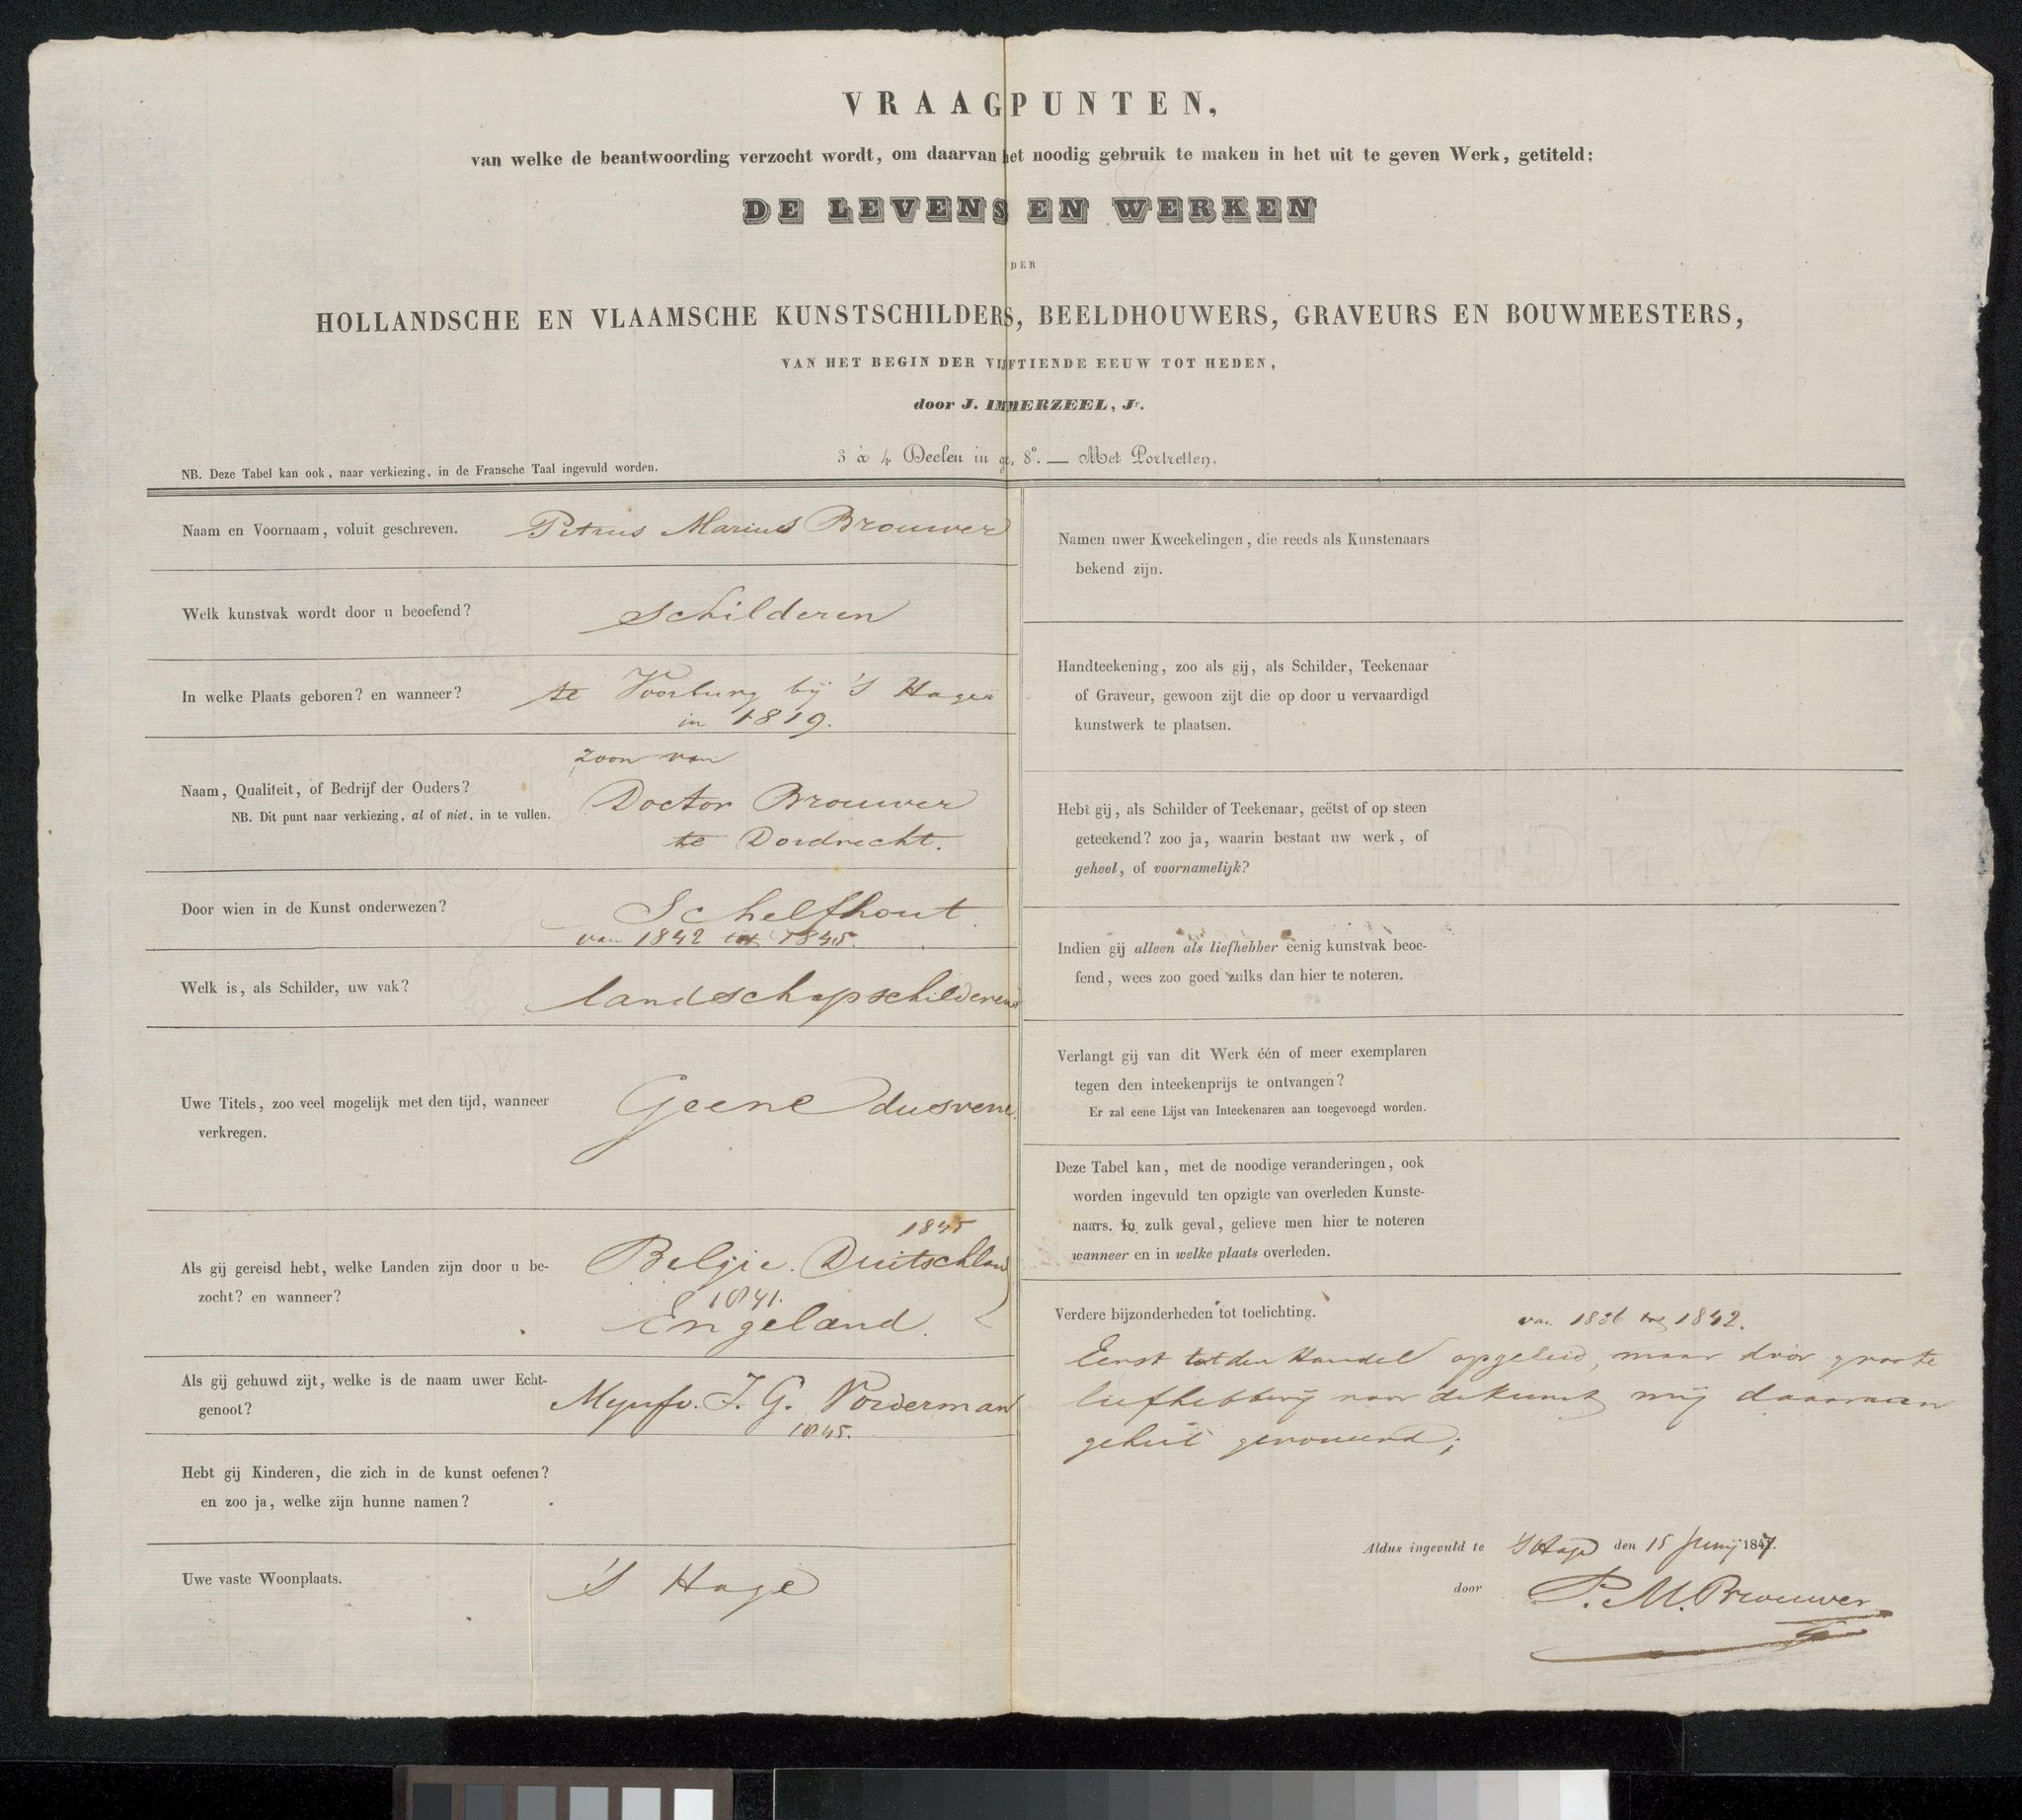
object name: questionnaire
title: Enquêteformulier ingevuld door Petrus Marius Brouwer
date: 1847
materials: ink, paper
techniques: pen, printing, writing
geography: the hague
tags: voorburg, deventer, draughtsman, petrus marius brouwer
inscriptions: inscription: ‘Vraagpunten,/ van welke de beantwoording verzocht wordt, om daarvan het noodig gebruik te maken in het uit te geven Werk, getiteld: De levens en werken/ der Hollandsche en Vlaamsche kunstschilders, beeldhouwers,/ graveurs en bouwmeesters, van het begin der vijftiende eeuw tot heden/ door J. Immerzeel, Jr.’, watermark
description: Bedoeld voor: Immerzeel, J. Jr., De levens en werken der Hollandsche en Vlaamsche kunstschilders, beeldhouwers, graveurs en bouwmeesters, van het begin der vijftiende eeuw tot heden, Amsterdam: J.C. van Kesteren, 1842-1843.